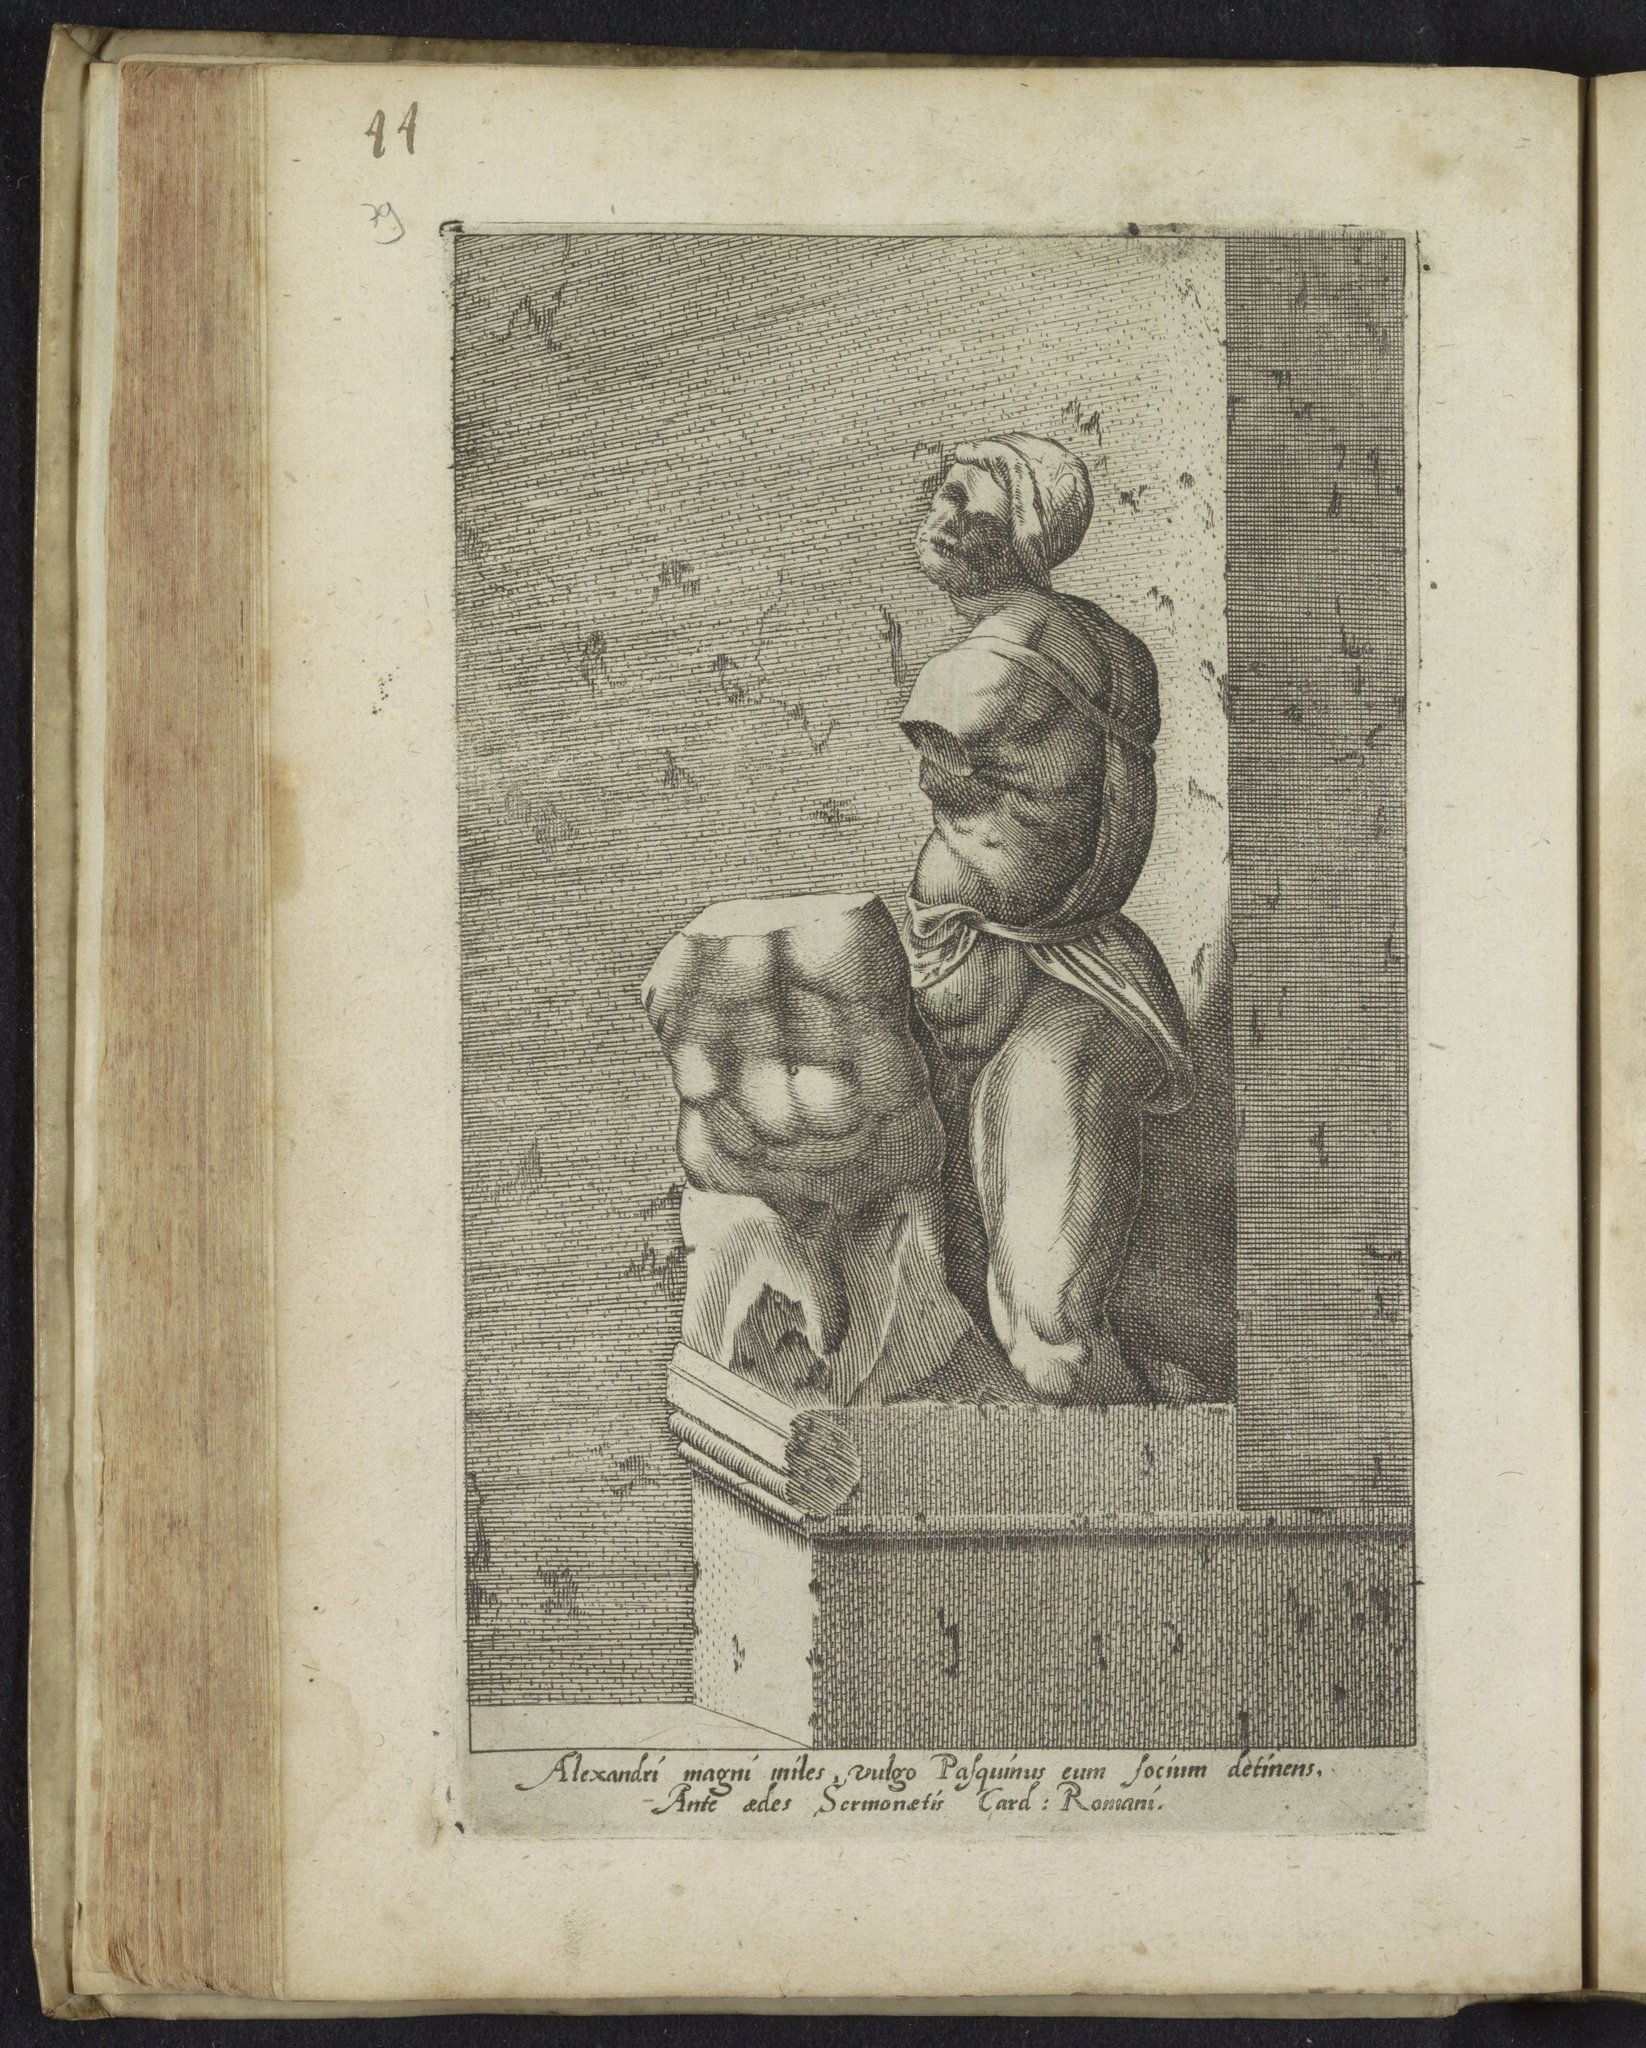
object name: album leaf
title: Sculptuur van Pasquino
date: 1584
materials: paper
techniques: engraving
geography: italy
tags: communication by means of 'statue parlanti', such as marforio and pasquino in rome, piece of sculpture, reproduction of a piece of sculpture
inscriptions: number: ‘44’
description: Sculptuur van Pasquino, naast het Palazzo Braschi, een van de pratende beelden in Rome. Onderschrift in het Latijn. Prent maakt deel uit van een album.